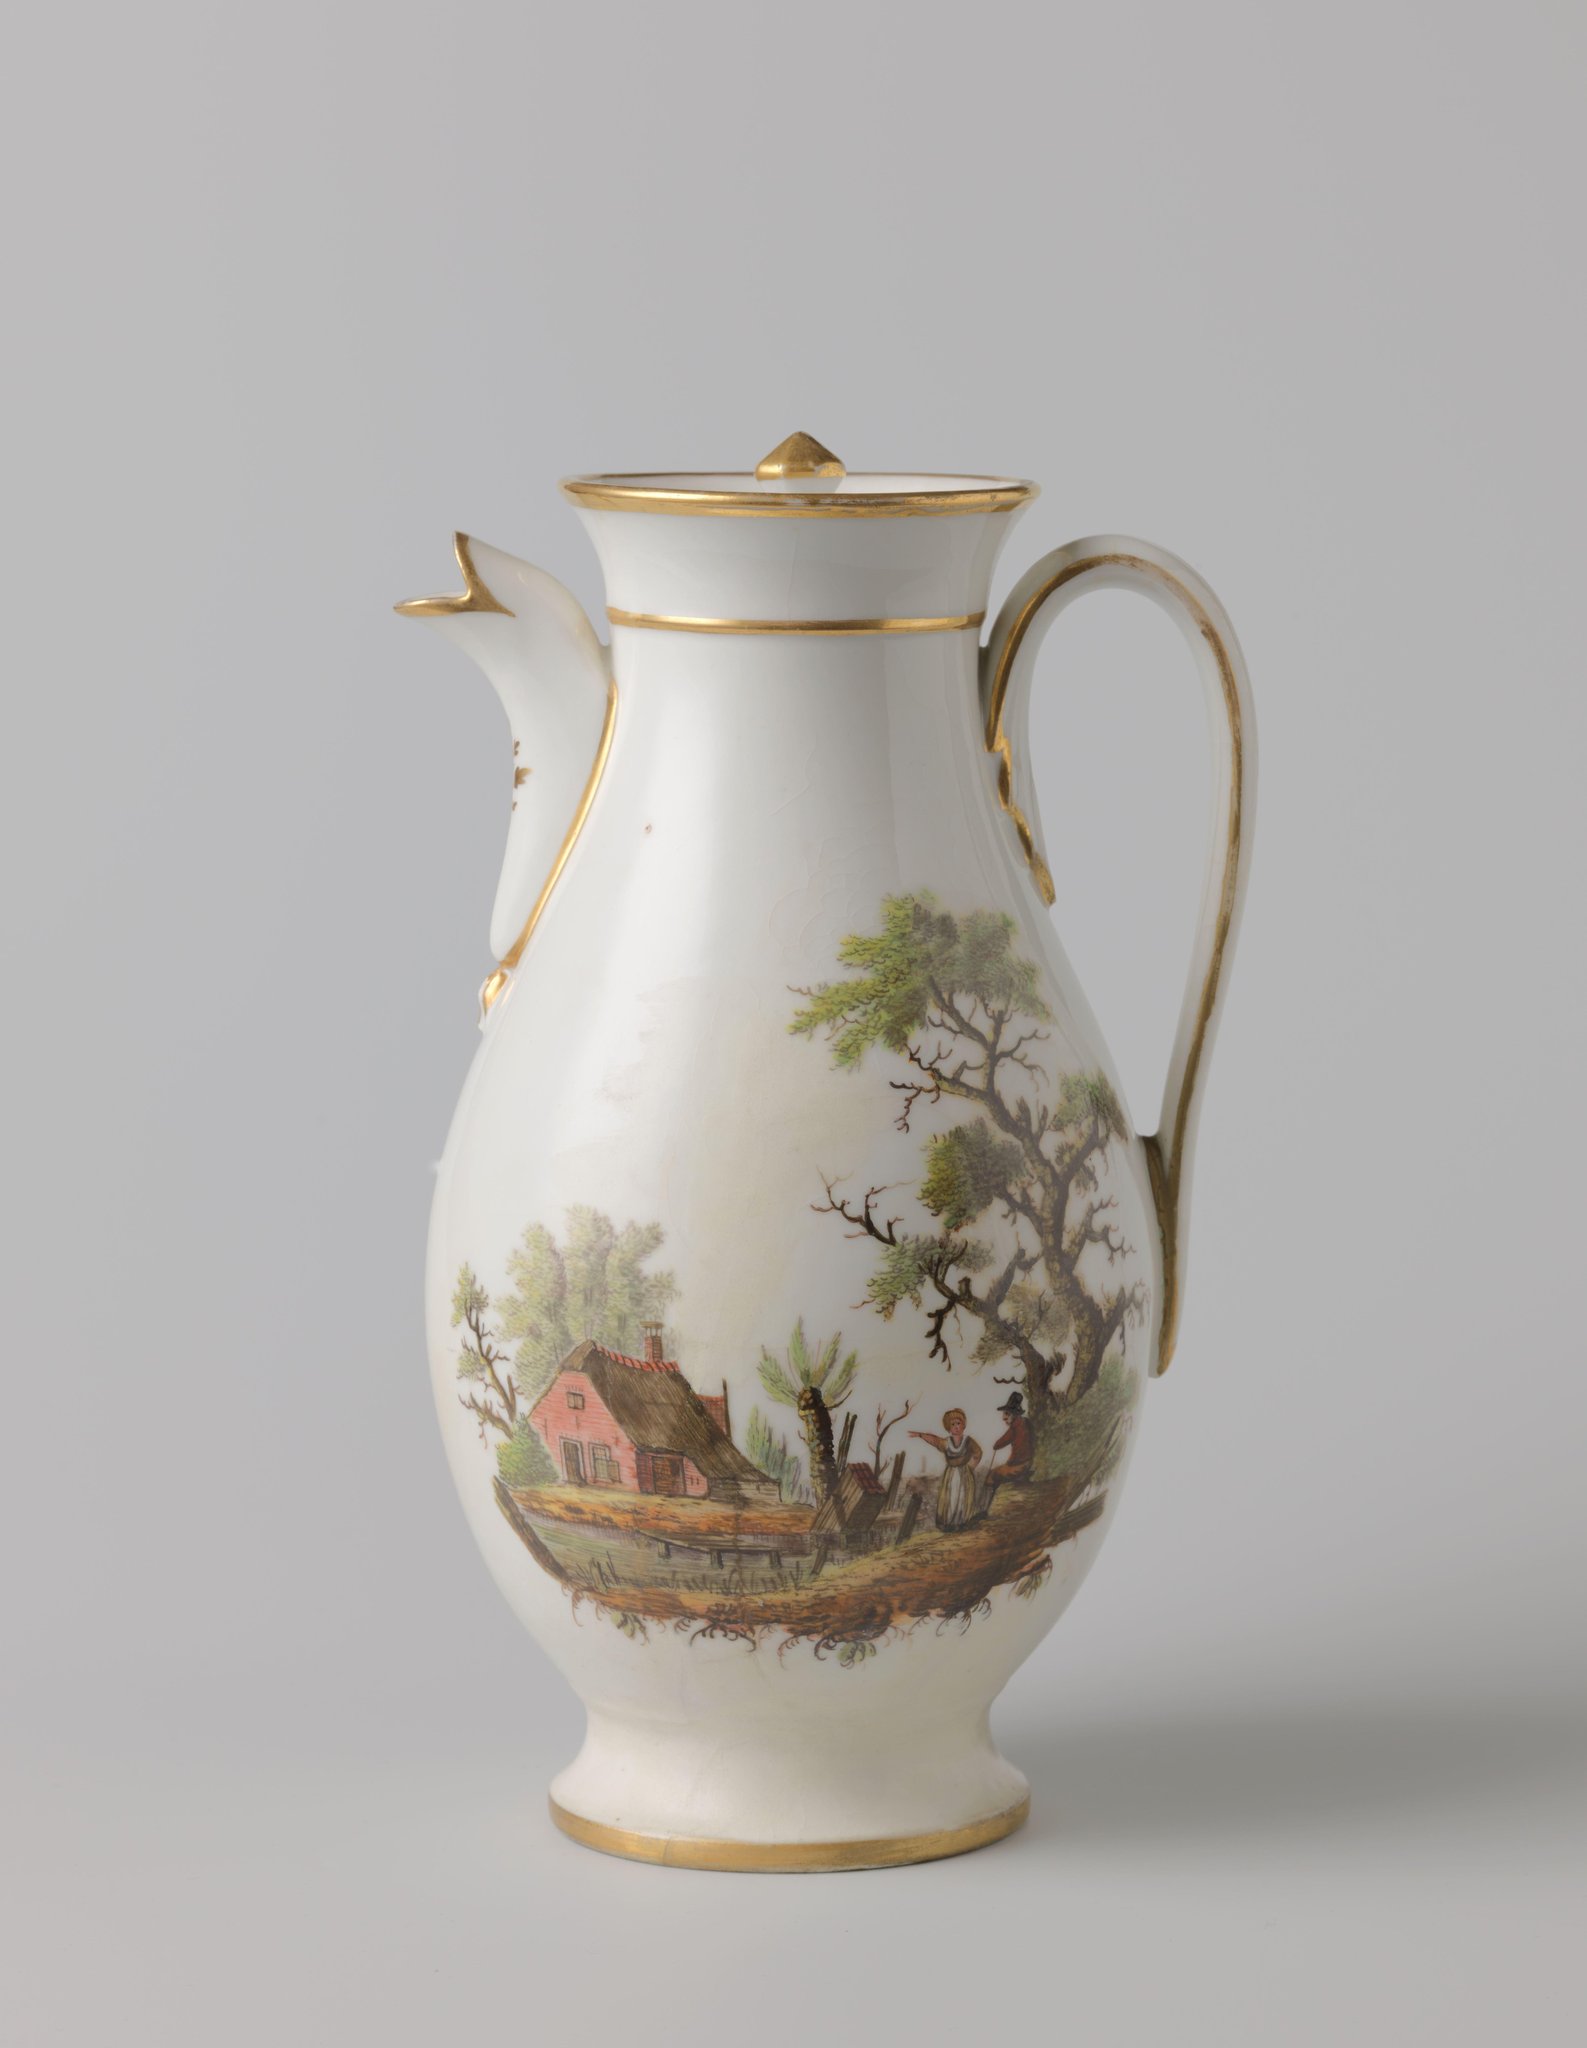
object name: coffee pot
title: Deksel van koffiekan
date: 1809-1814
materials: porcelain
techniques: painted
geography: nieuwer-amstel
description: Deksel van koffiekan, peervormig en veelkleurig beschilderd met man leunend op stok in een landschap. Gouden rand en knop.